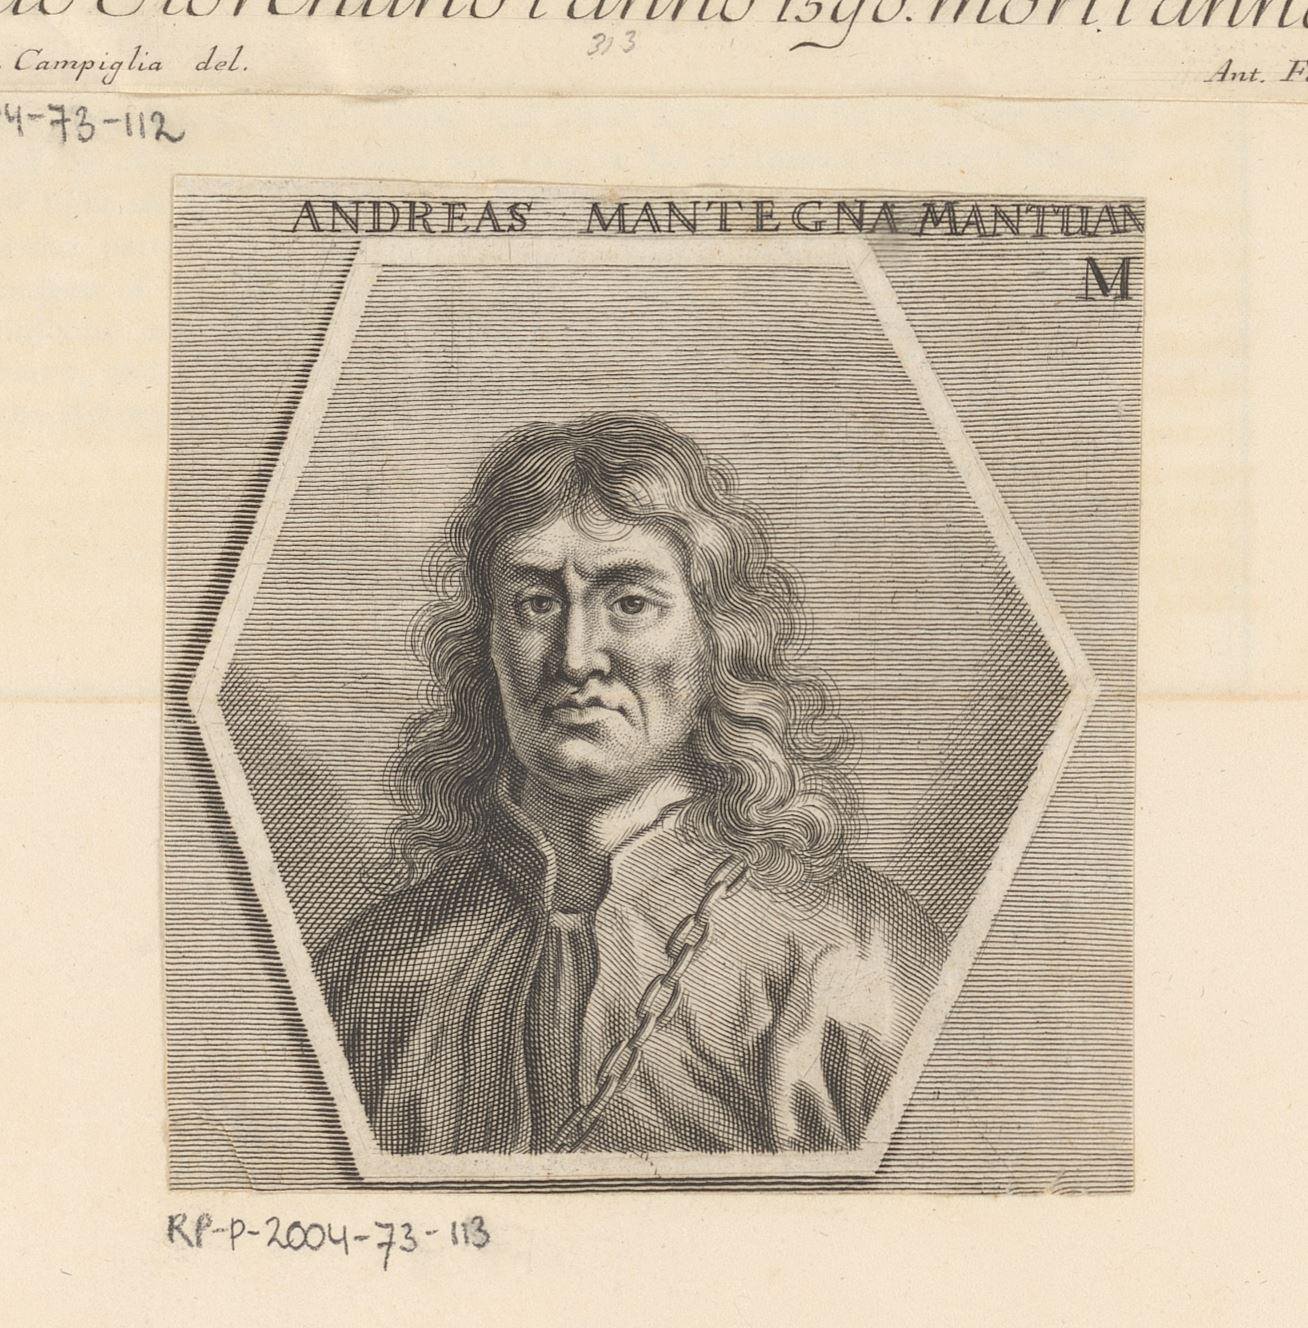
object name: album leaf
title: Portret van Andrea Mantegna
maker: philipp kilian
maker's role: print maker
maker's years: 1628-1693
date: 1768-1775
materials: paper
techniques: engraving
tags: andrea mantegna, historical persons, portrait, self-portrait of painter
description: Andere staat van prent gebruikt in: Sandrart, Joachim von. Teutsche Academie der Bau- Bildhauer- und Maler-Kunst: worinn die Regeln und Lehrsätze dieser Künste gegeben. 14 dln. Neurenberg: erven Johann Andreas Endter, [1774], dl. 7, p. L. De samensteller heeft deze prent in het album geplakt als illustratie bij: Pilkington, Matthew en Johann Heinrich Füssli. A dictionary of painters, from the revival of the art to the present period. 4 dln. Londen: John Crowder, 1805, dl. 2, p. 313.